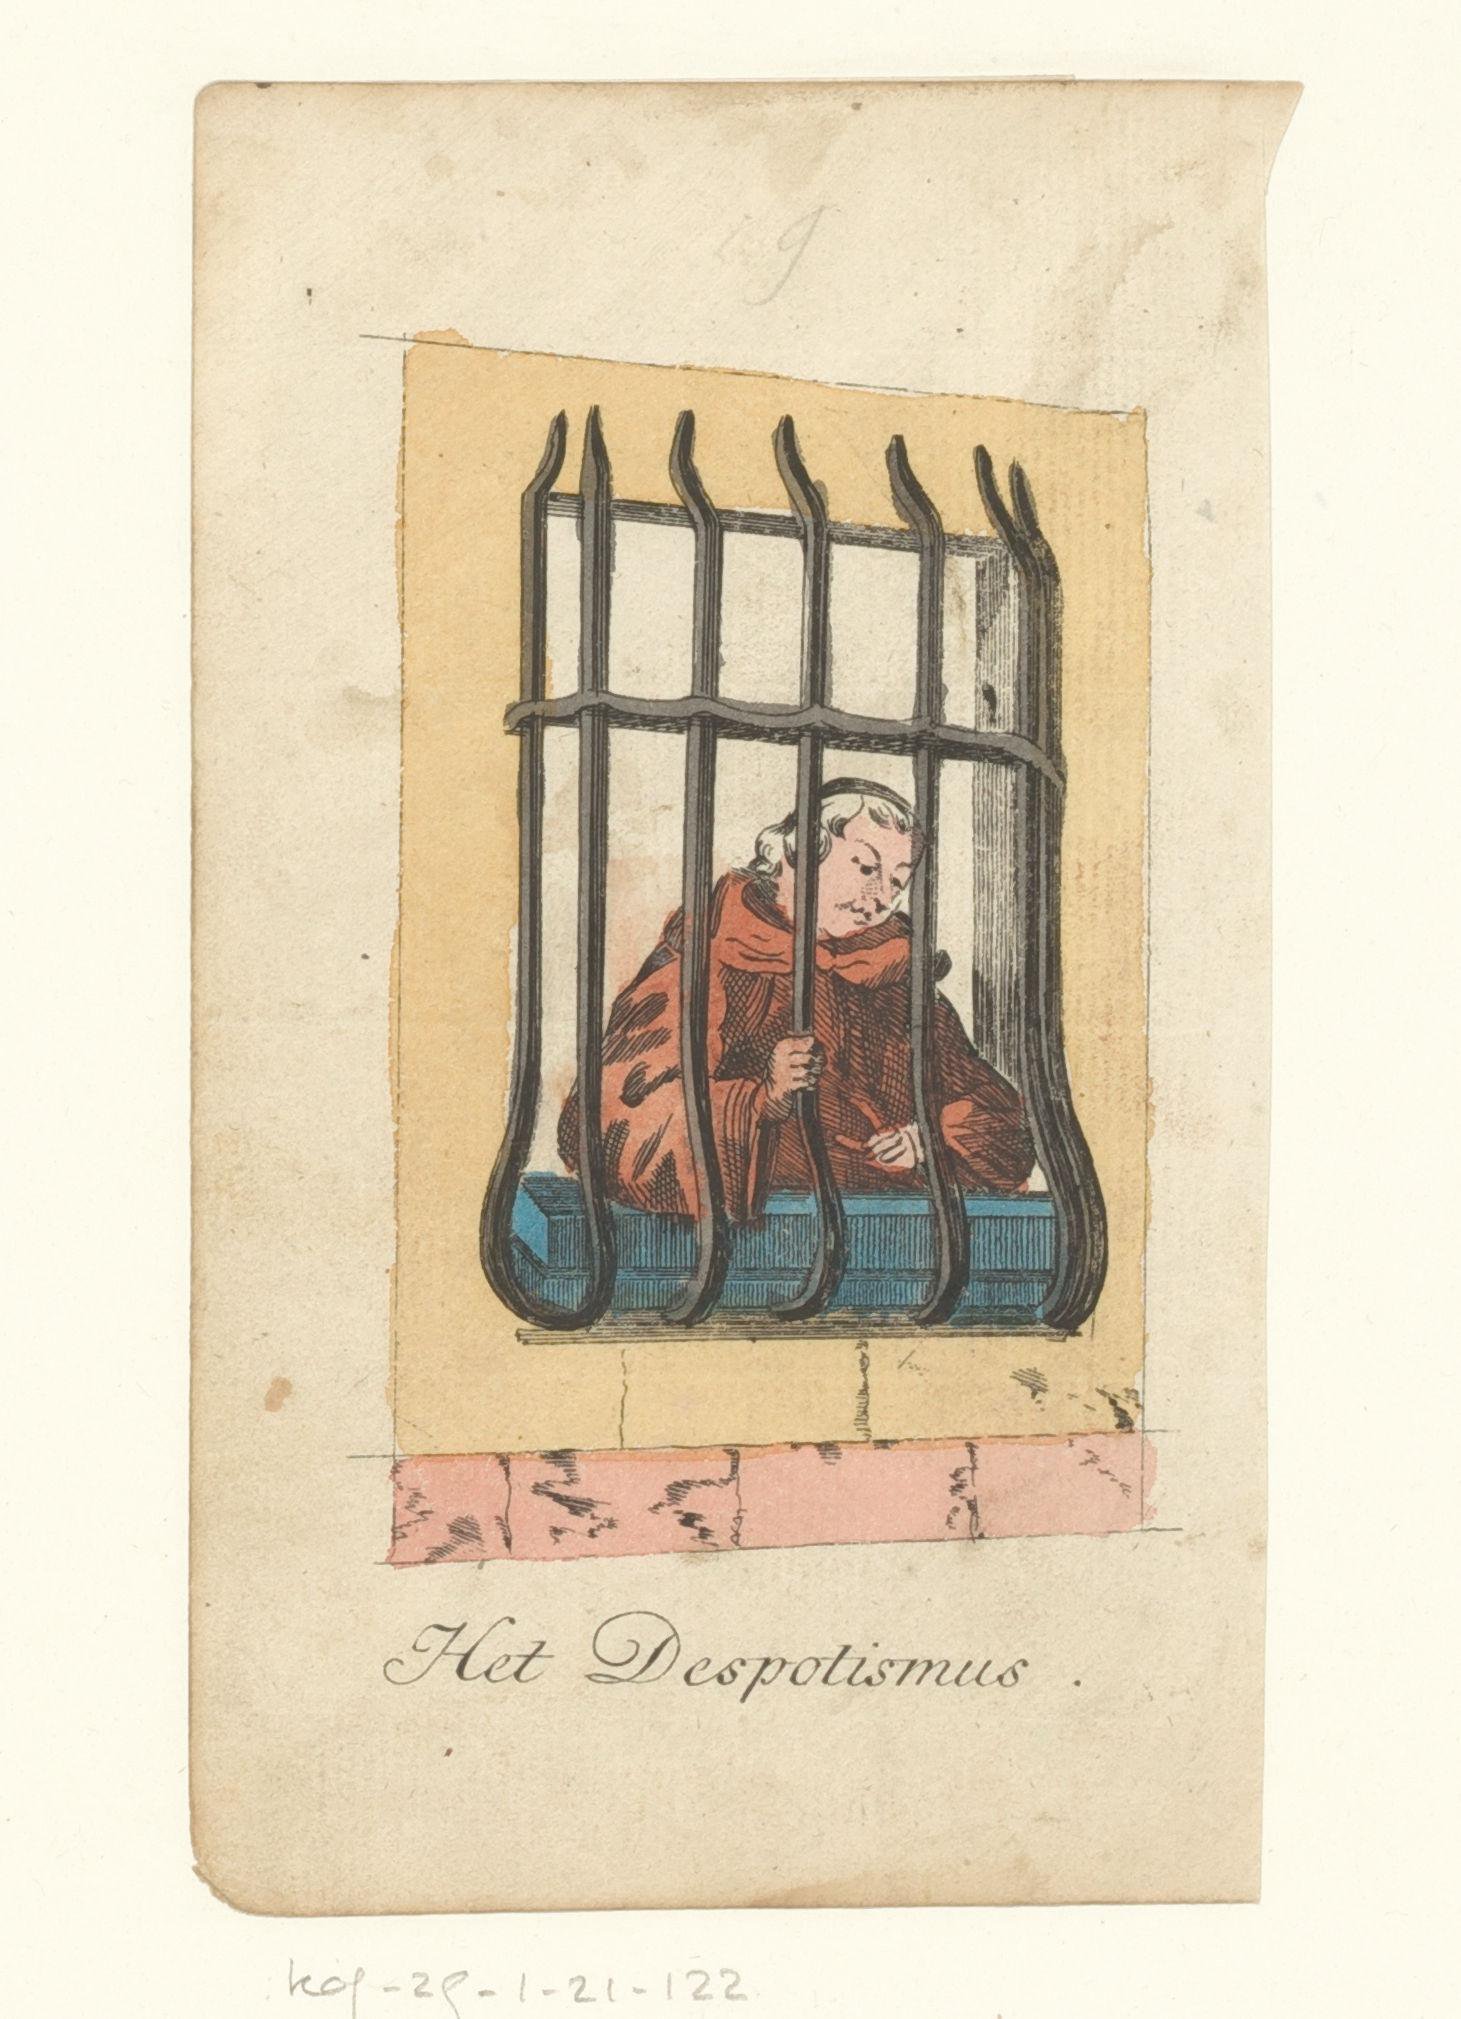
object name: print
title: Het Despotismus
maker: Anonymous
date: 1821-1829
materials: paper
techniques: engraving, etching, hand coloring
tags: prison, jail, monk(s), friar(s)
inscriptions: stamp, collector's mark: Lugt 1641a, collector's mark: Lugt 1641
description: Prent waarschijnlijk uit: Hans Beuling, of St. Nicolaas- Nieuwejaars- Vastenavond- en kermisvermaak. Voor kinderen. Rotterdam: B. Schuurling, s.a [1821-1829]. uitgave. Volgens de Atlas van Stolk ook gebruikt in: De nieuwe toverlantaarn. Amsterdam: s.n., 1797.